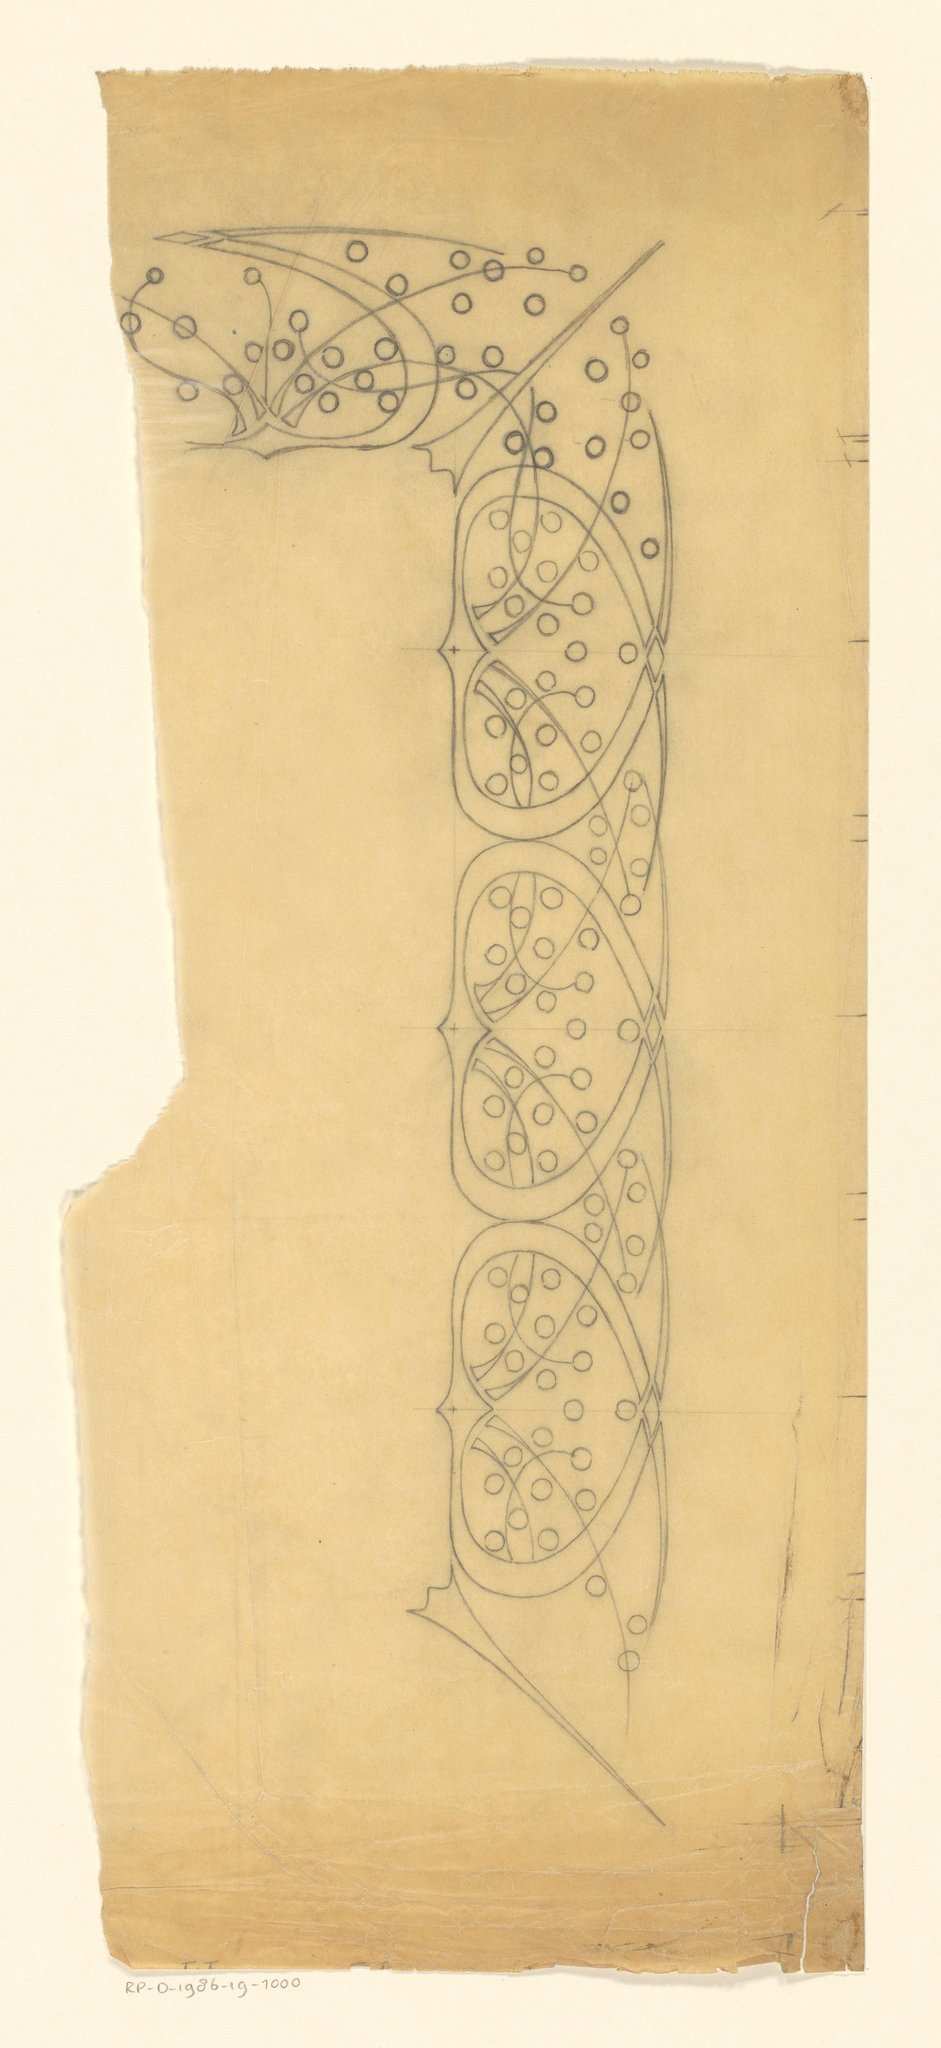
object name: design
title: Fragment van een ornamenteel kader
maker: reinier willem petrus de vries (1874-1953)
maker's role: draughtsman, print maker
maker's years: 1874-1953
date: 1884-1952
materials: pencil, paper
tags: ornaments ~ art